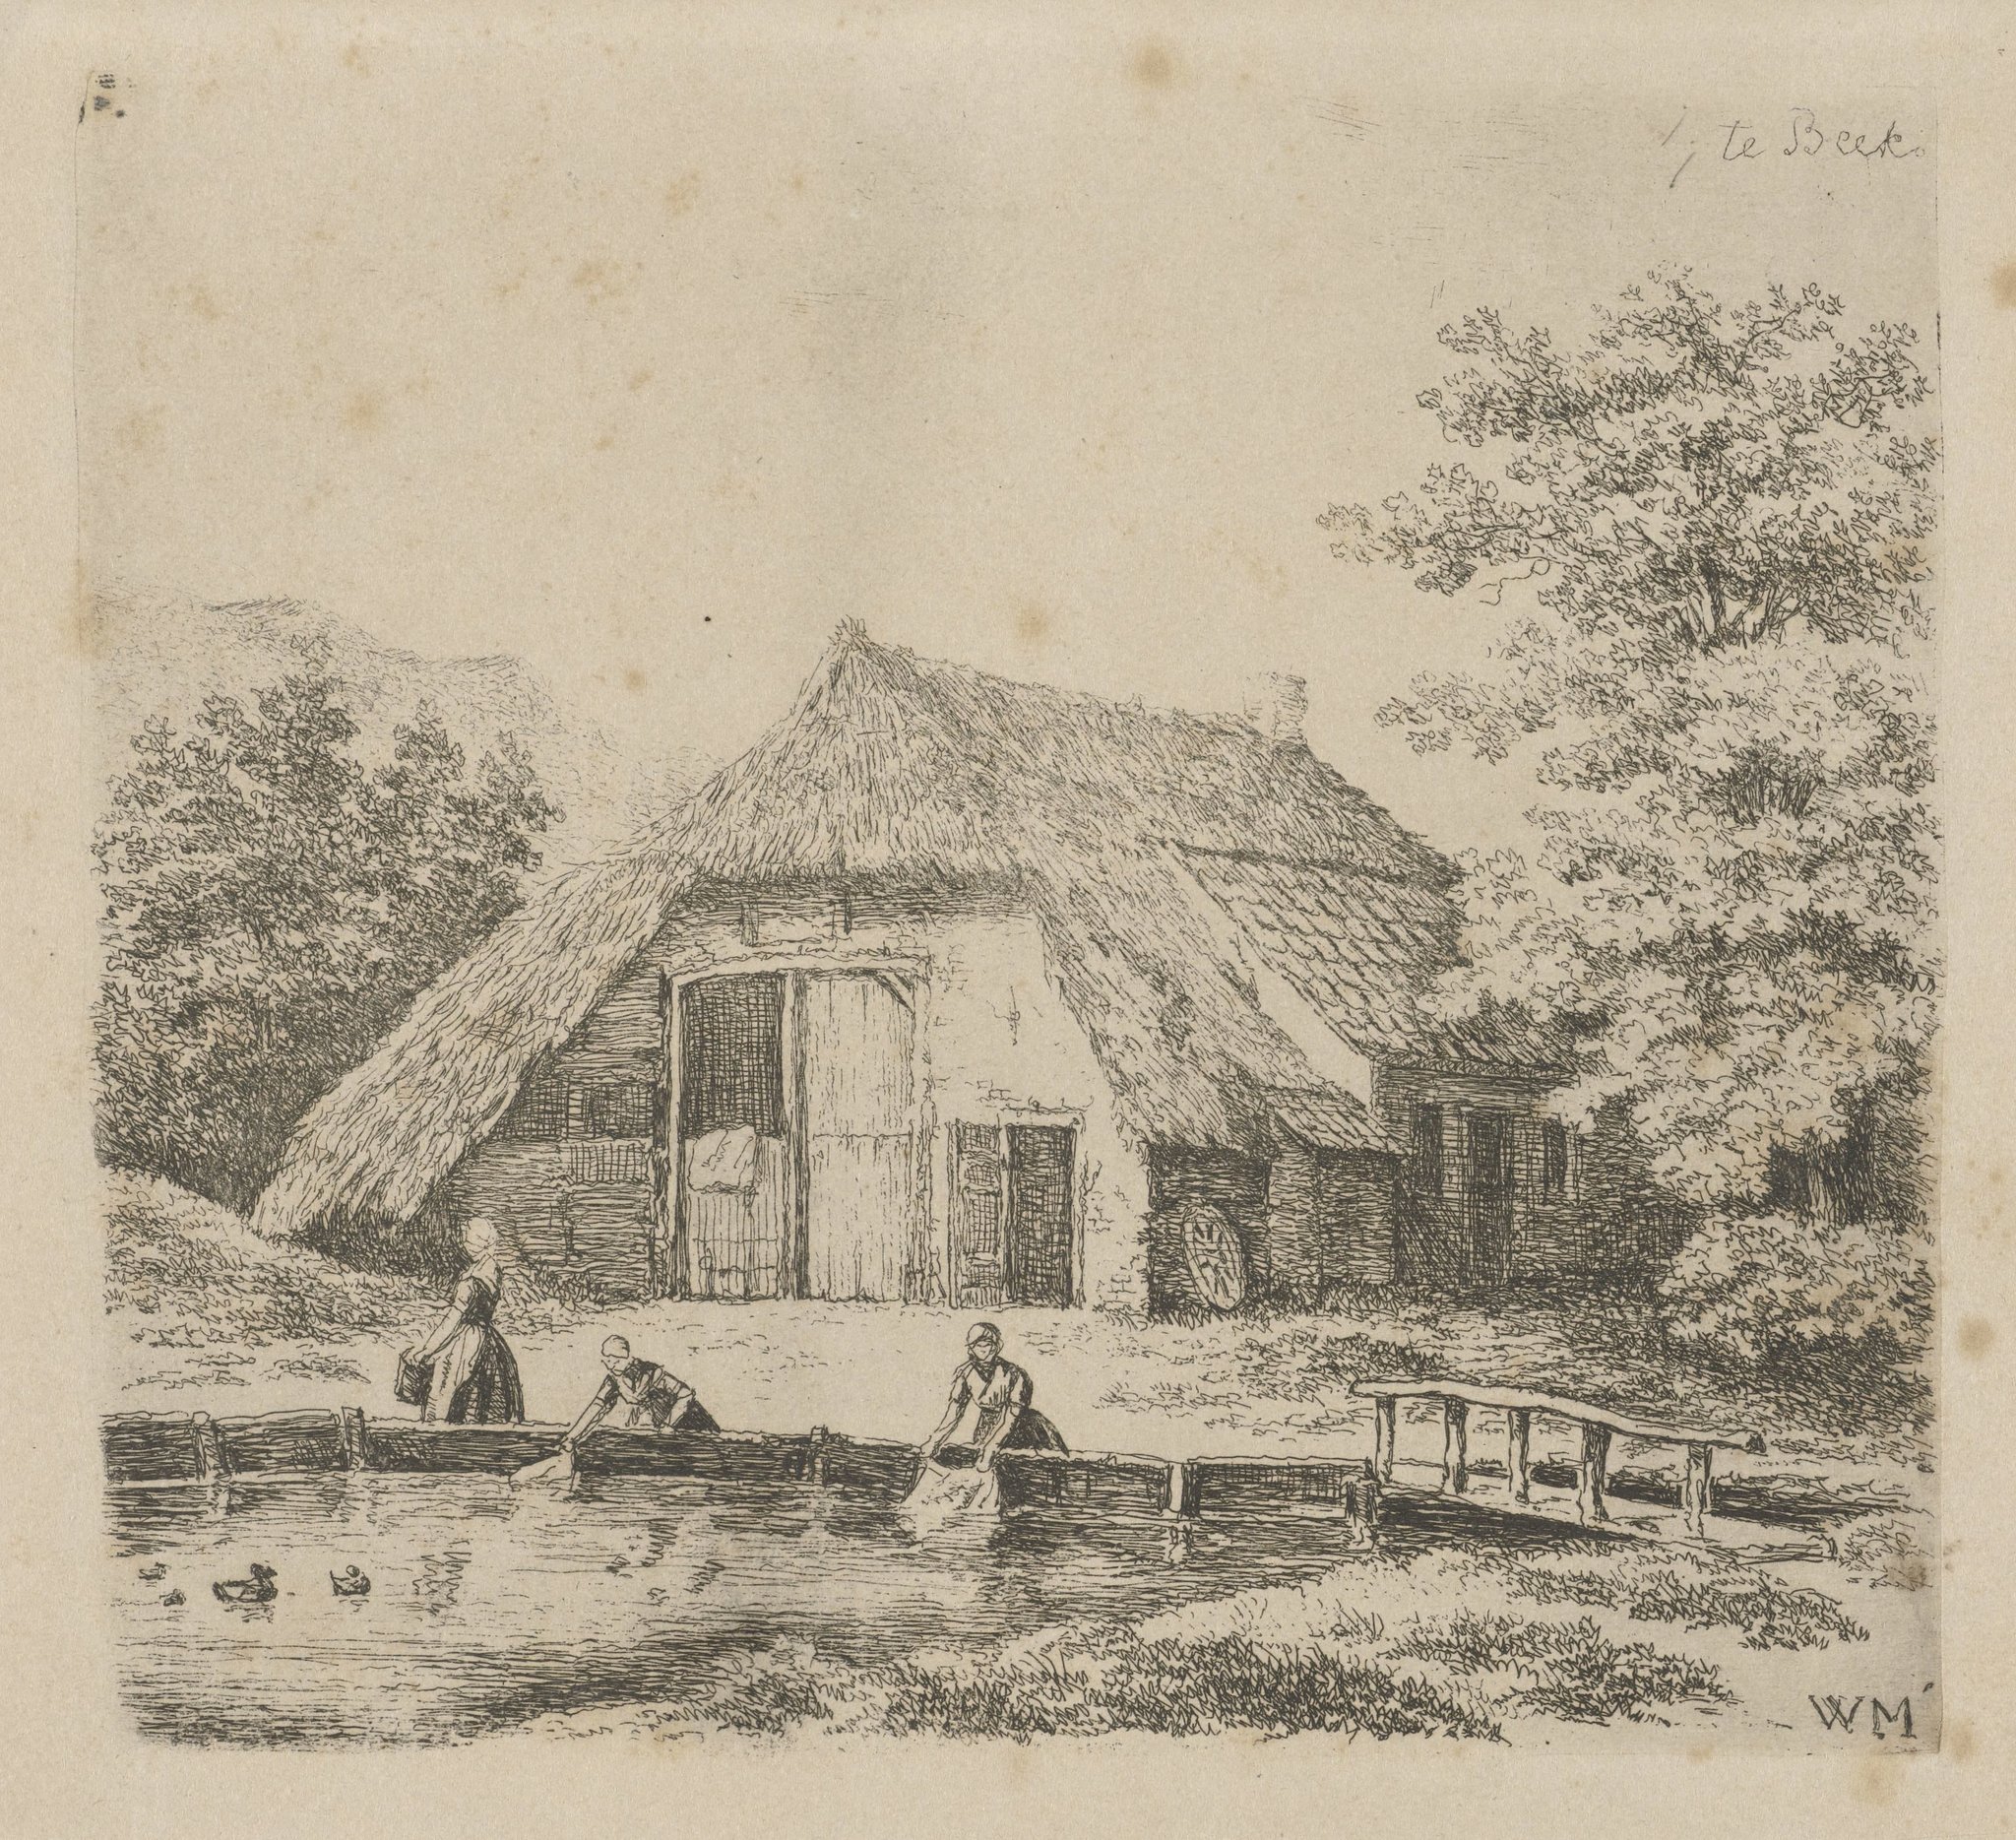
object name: print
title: Drie vrouwen doen de was in Beek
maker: christiaan wilhelmus moorrees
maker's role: draughtsman, print maker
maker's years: 1801-1867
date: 1811-1867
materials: paper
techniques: etching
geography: netherlands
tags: laundering, farm (building)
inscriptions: collector's mark: Lugt 2228, collector's mark: Lugt 1485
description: Drie vrouwen doen de was bij het water voor een boerderij in Beek.